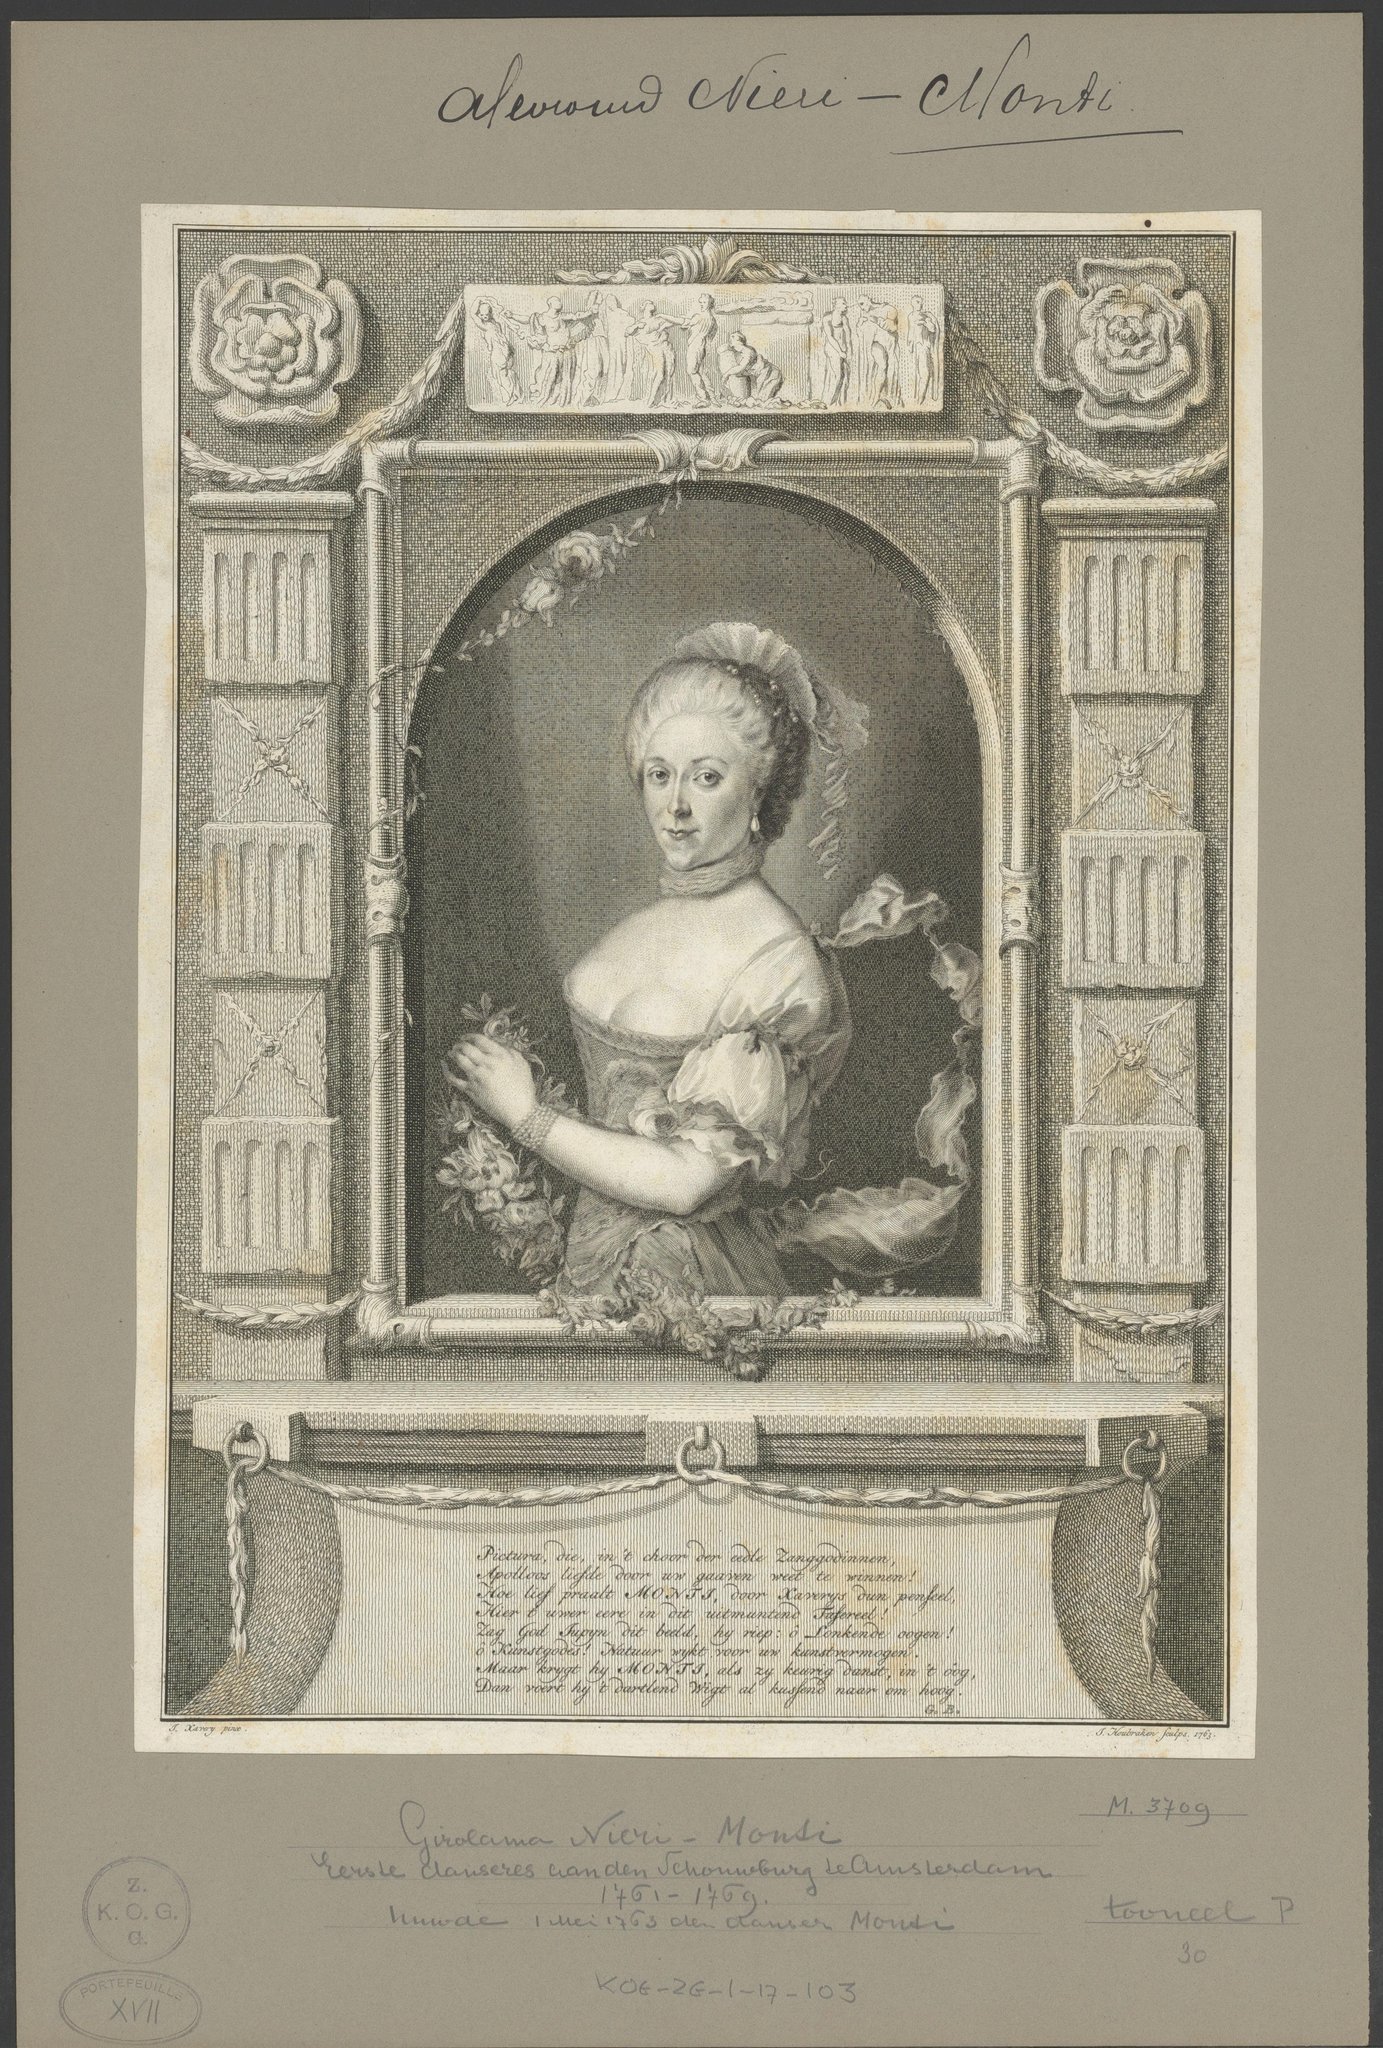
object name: print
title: Portret van Gomana Girolama Monti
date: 1763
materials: paper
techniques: engraving, etching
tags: historical persons - bb - woman, female dancer, portrait of dancer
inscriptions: stamp, collector's mark: Lugt 1641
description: Portret van de danseres Gomana Girolama Monti, in een architectonisch ornamenteel venster, met in haar hand een bloemen guirlande. Boven het portret een klassiek bas-reliëf met figuren. Onderaan een richel van een vensterbank en daaronder een achtregelig vers in het Nederlands. Onderwerpsrubrieken binnen de Atlas Zeden en Gewoonten: Tooneel, Portretten van toneelspelers.